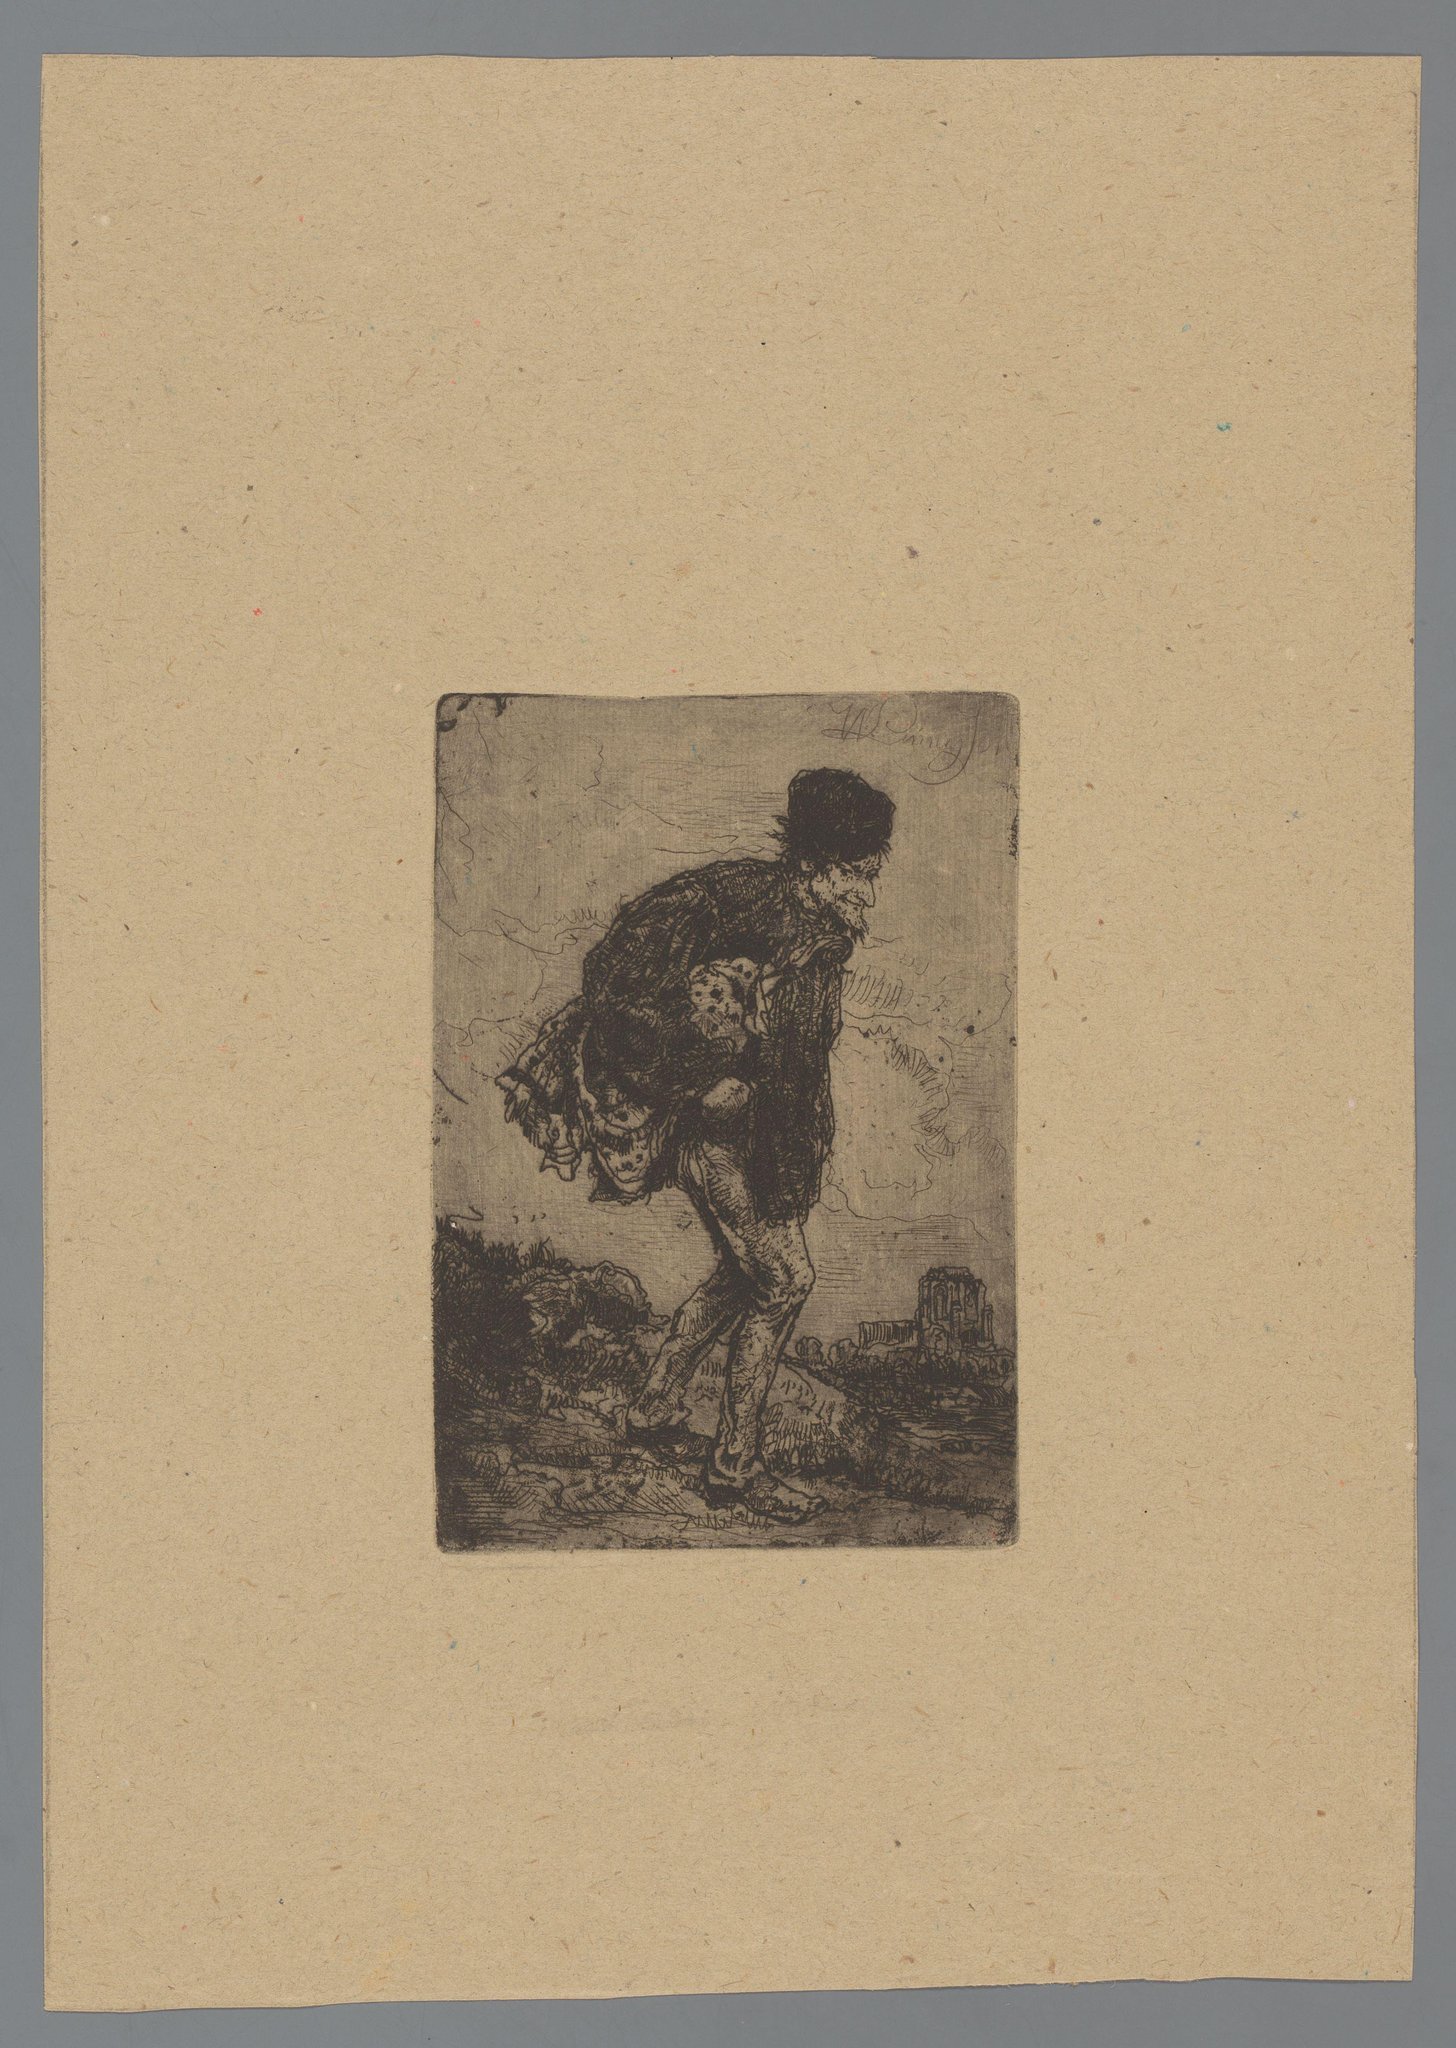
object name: print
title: Lopende man met onder zijn arm een in een doek gewikkelde viool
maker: willem linnig (ii)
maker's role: print maker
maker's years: 1842-1890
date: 1852-1890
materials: paper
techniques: etching, intaglio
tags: musician - cc - out of doors, violin, fiddle - cc - out of doors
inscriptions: collector's mark: Lugt 2228